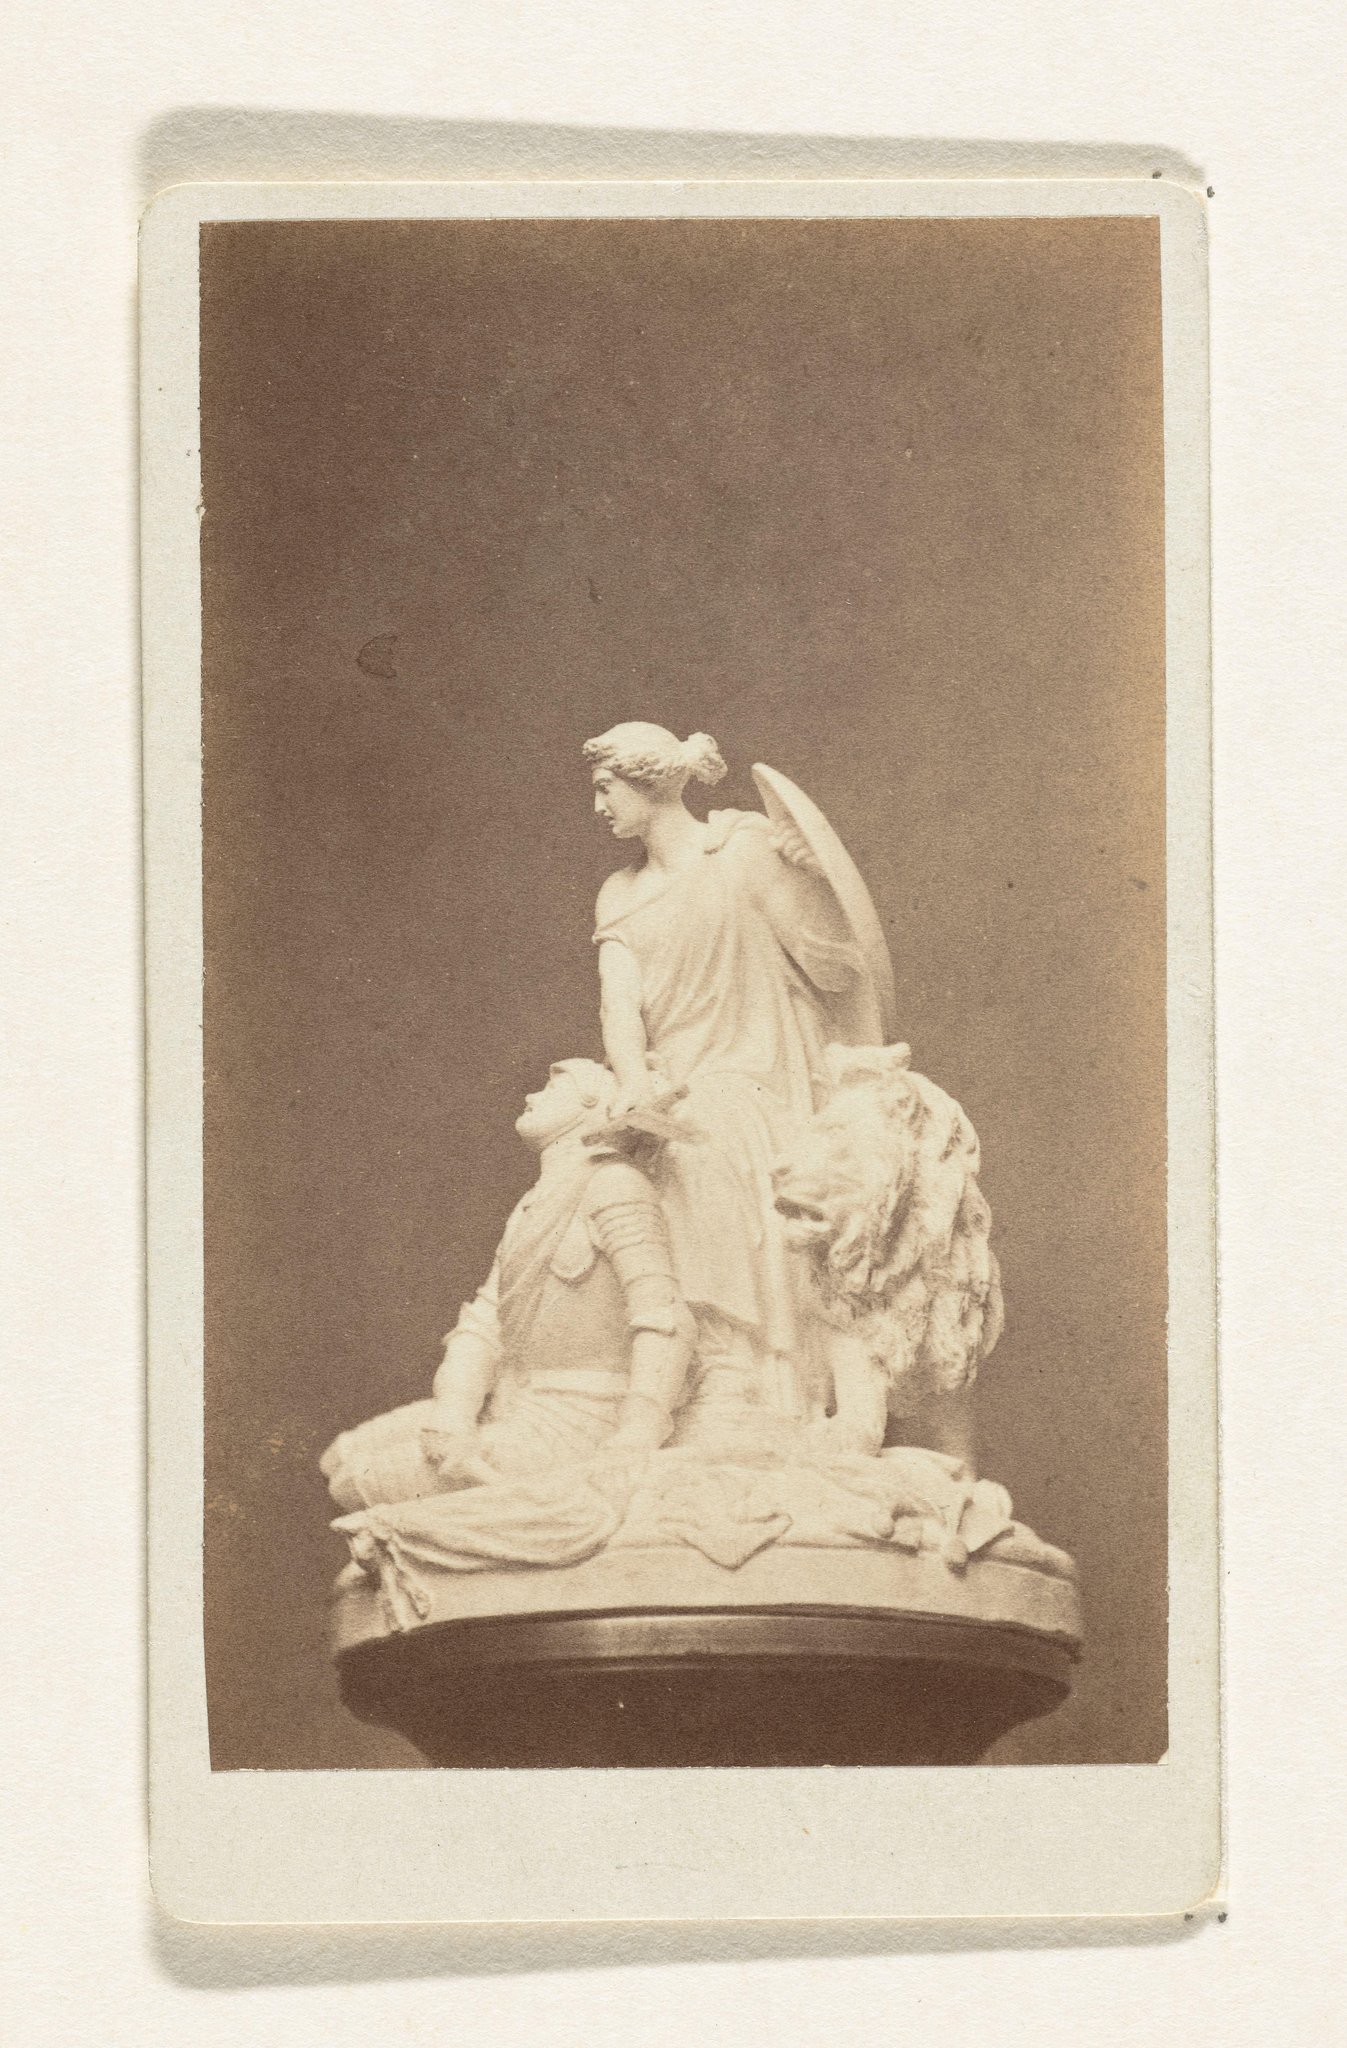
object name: carte de visite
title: Vier foto's van het ontwerp voor een monument voor de slag bij Heiligerlee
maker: johannes hinderikus egenberger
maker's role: draughtsman, print maker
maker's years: 1822-1897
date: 1868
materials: cardboard, paper, photographic support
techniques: albumen print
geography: groningen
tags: personifications of countries, nations, states, districts, etc., piece of sculpture, reproduction of a piece of sculpture, monument, statue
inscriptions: collector's mark: Lugt 2228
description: Model voor een monument voor de slag bij Heiligerlee (23 mei 1568) onthuld op 23 mei 1868. Het beeld stelt voor: de stervende graaf Adolf van Nassau met de Nederlandse Leeuw en de Nederlandse Maagd. Gipsmodel van vier kanten gefotografeerd.